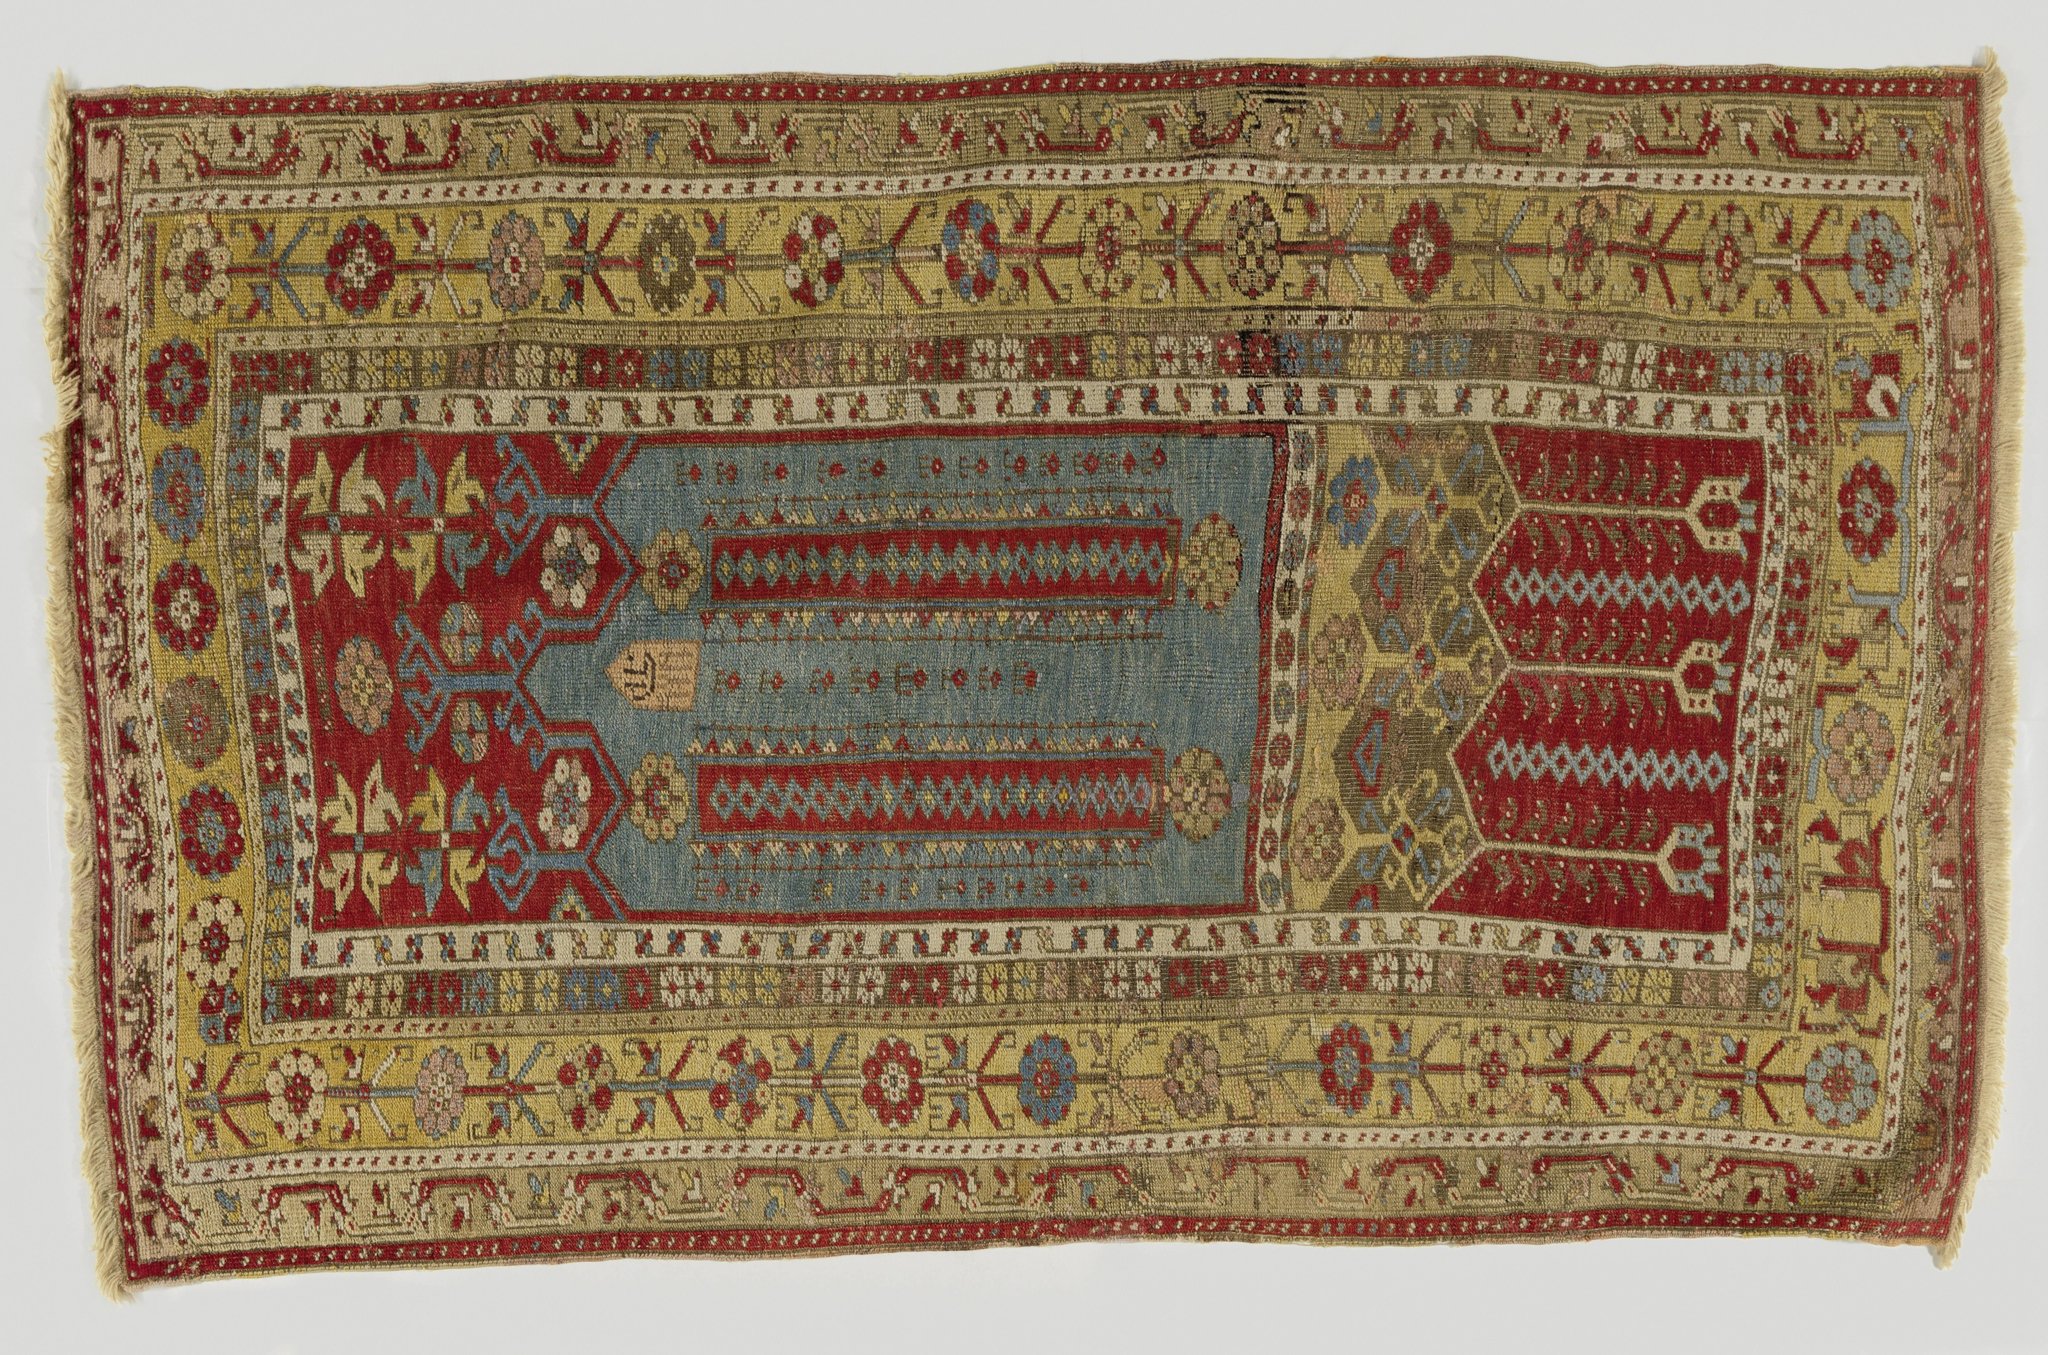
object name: oriental rug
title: Bidkleed, z.g. kolommenbidkleed, met benedenpaneel en jaartal, LADIK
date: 1800-1900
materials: wool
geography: ladik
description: Bidkleed, z.g. kolommenbidkleed, met benedenpaneel en (onduidelijk) jaartal, LADIK. Middenveld: lichtblauwe mihrab met driedelige, in het midden hogere topgevel, een jaartal (1211? = 1796?), zwevende kolommen en slierten motieven. Op rode zwikken staan vier anjelieren in geel met blauw en geel met wit. Driedubbel zigzagpaneel van oker en bruin, ingrijpend in een rood benedenpaneel met drie afhangend tulpen in wit, waartussen een zigzagschaarlijn. Randen: veelvoudig. De hoofdrand is in okergeel, waarop rozetbloemen aan een rechte middenstengel groeien in rood en bruin. Twee binnenzomen, resp. in wit met hoekige rank en met rozetten. De buitenzoom in lichtbruin met eikelrank. Er tussen gestippelde veelkleurige lijsten.